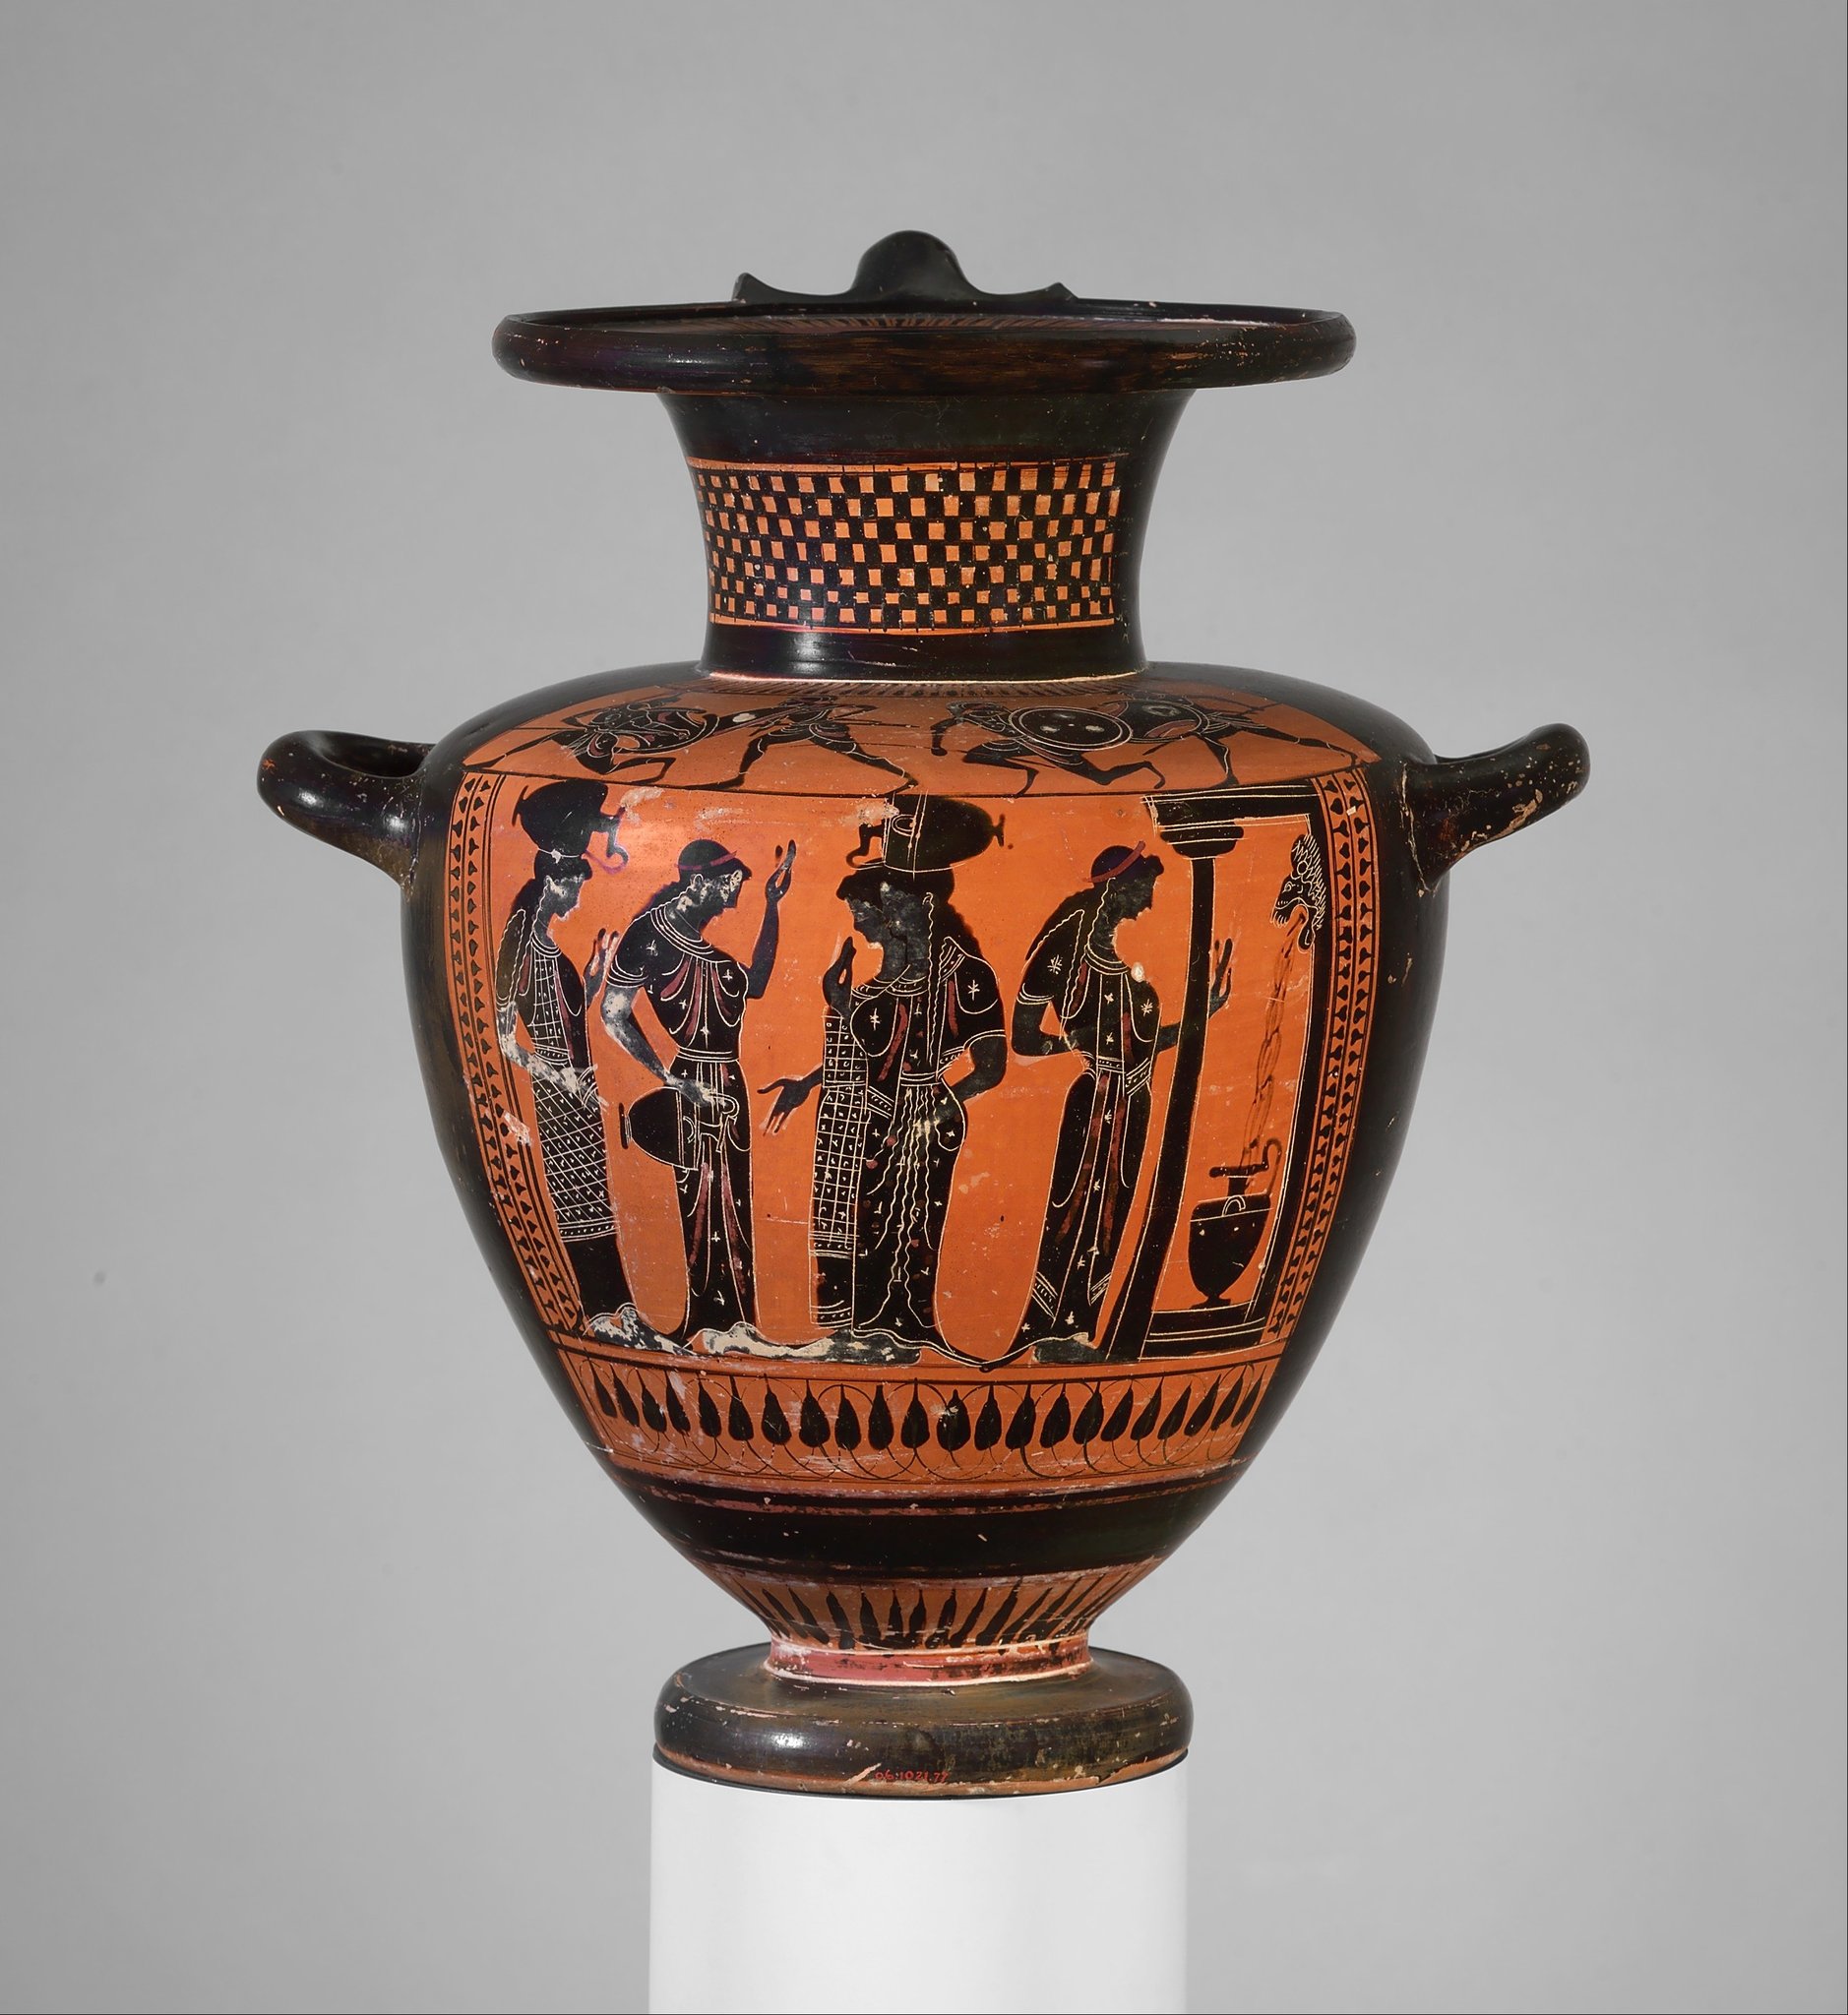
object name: hydria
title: Terracotta hydria (water jar)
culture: greek, attic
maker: class of hamburg 1917.477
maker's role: artist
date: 510-500 BCE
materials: terracotta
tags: fountains,battles,men,women